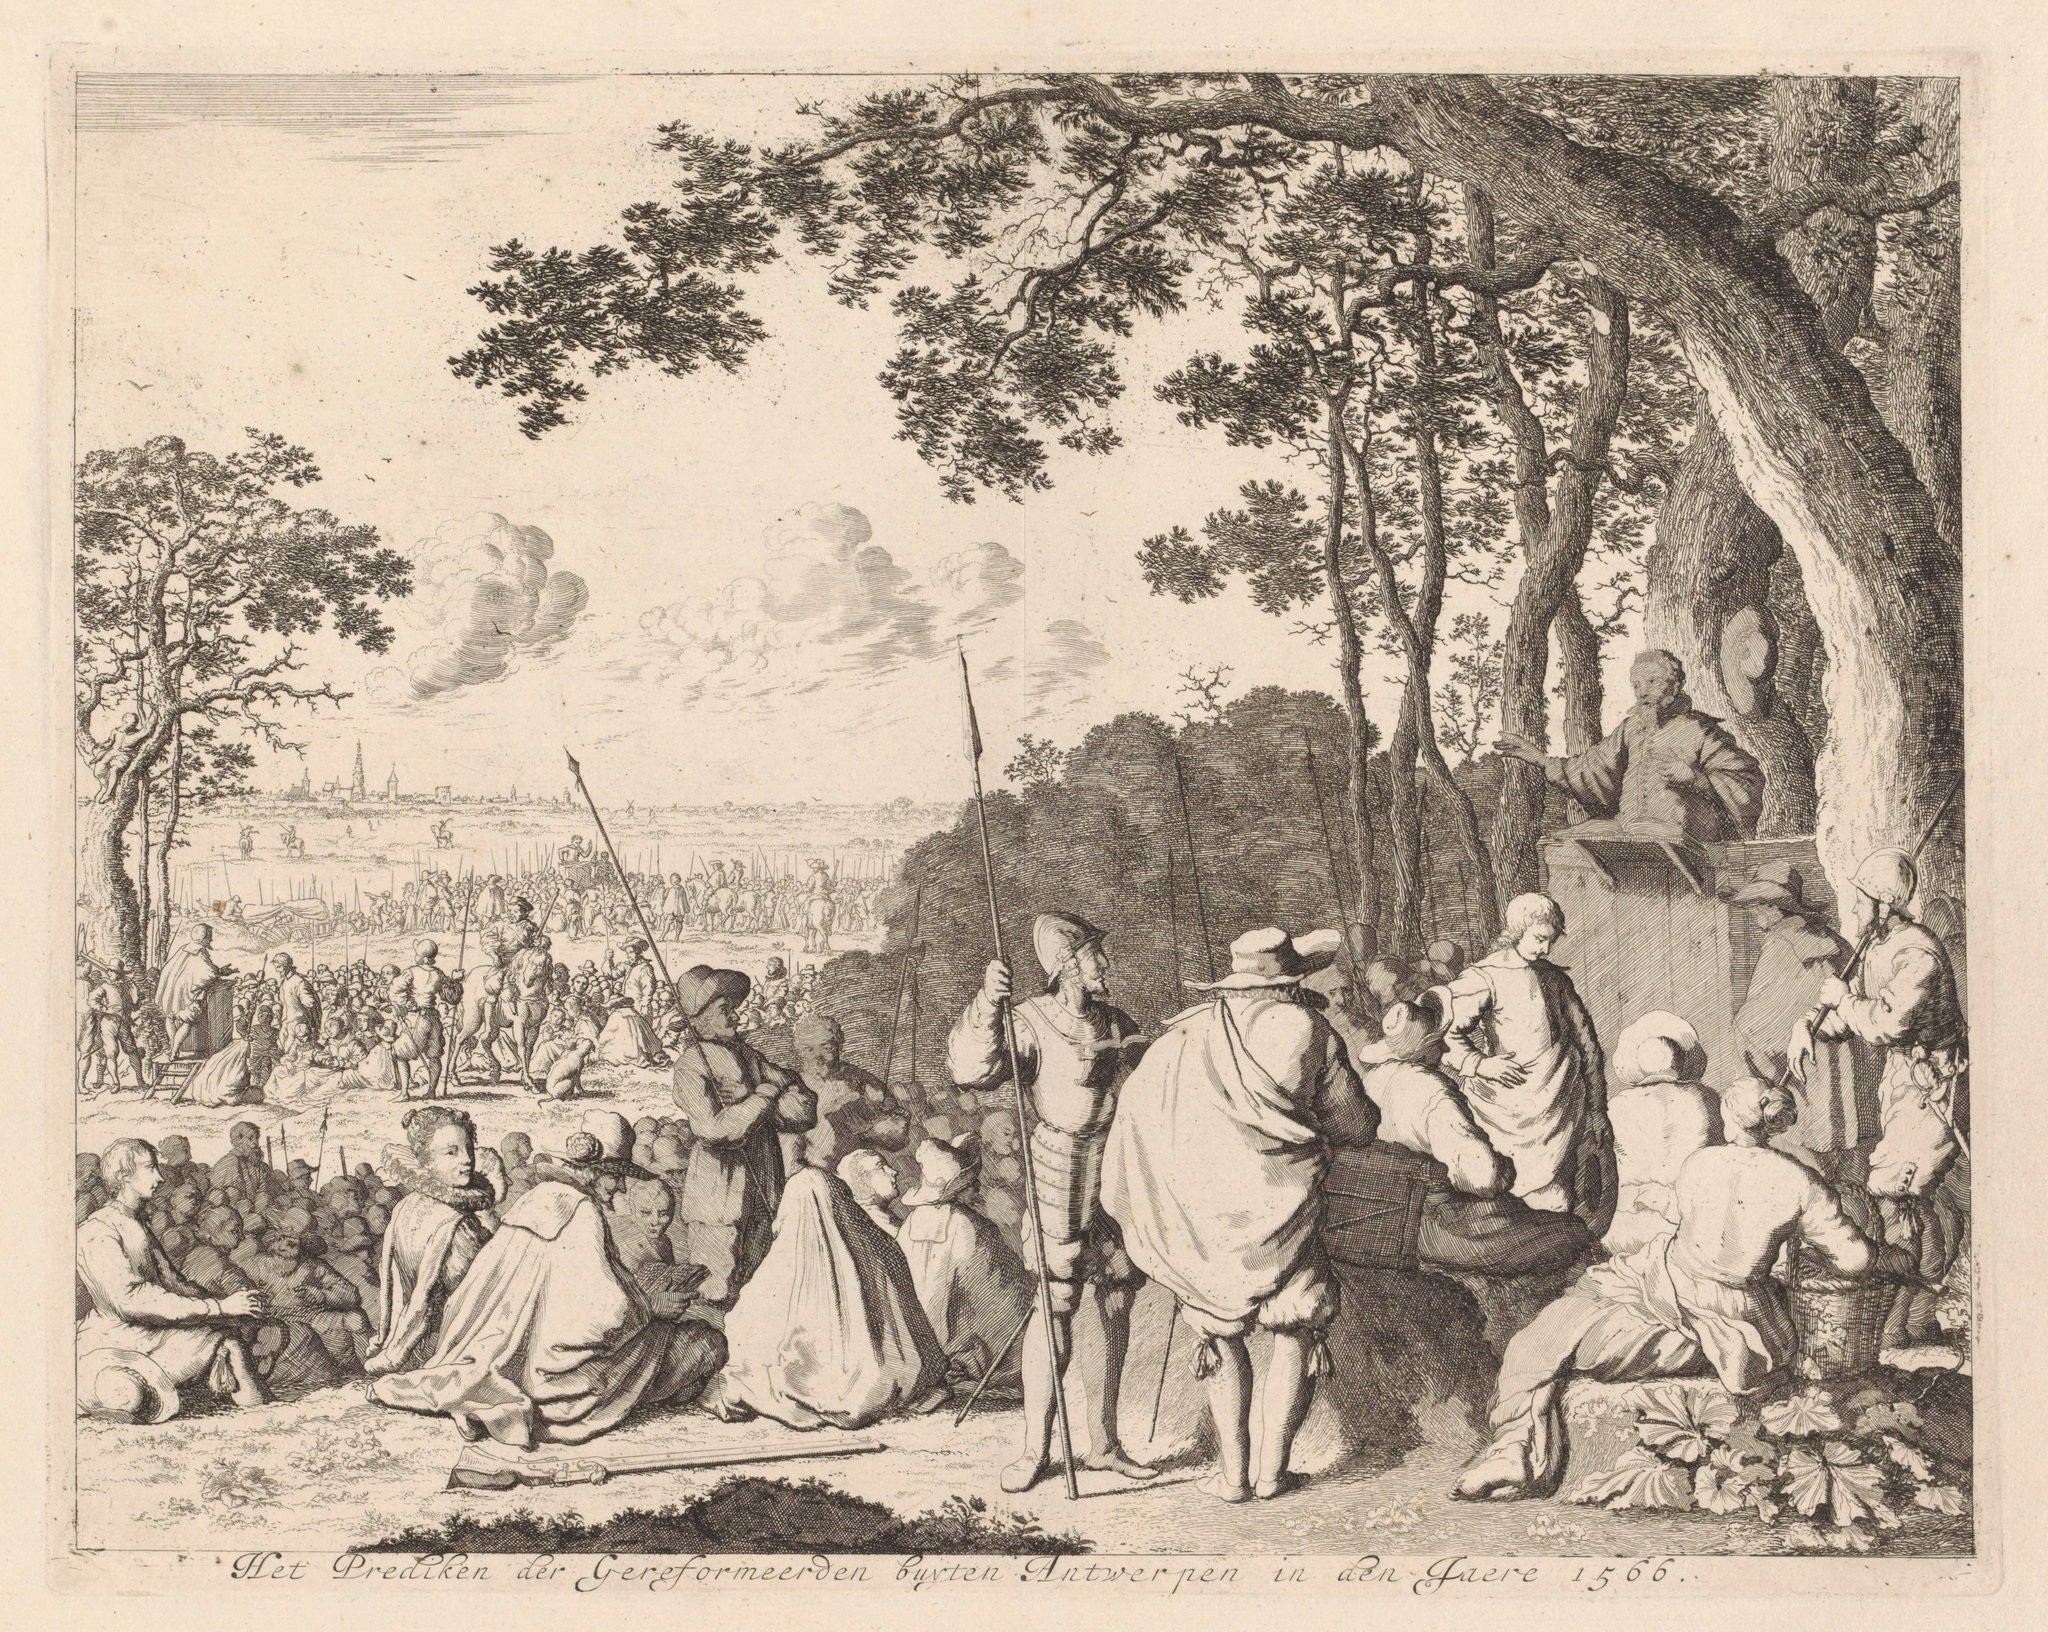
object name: print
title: Hagenpreken buiten Antwerpen, 1566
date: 1679-1684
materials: paper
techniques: etching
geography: amsterdam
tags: sermon ~ protestant service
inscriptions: collector's mark: Lugt 240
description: Hagenpreken buiten Antwerpen, 14 juni 1566. Calvinistische bijeenkomsten in de bossen, in de verte de stad Antwerpen. Op de voorgrond spreekt een predikant onder een boom. Onder de toehoorders bevinden zich enkele gewapende calvinistische ordebewakers.